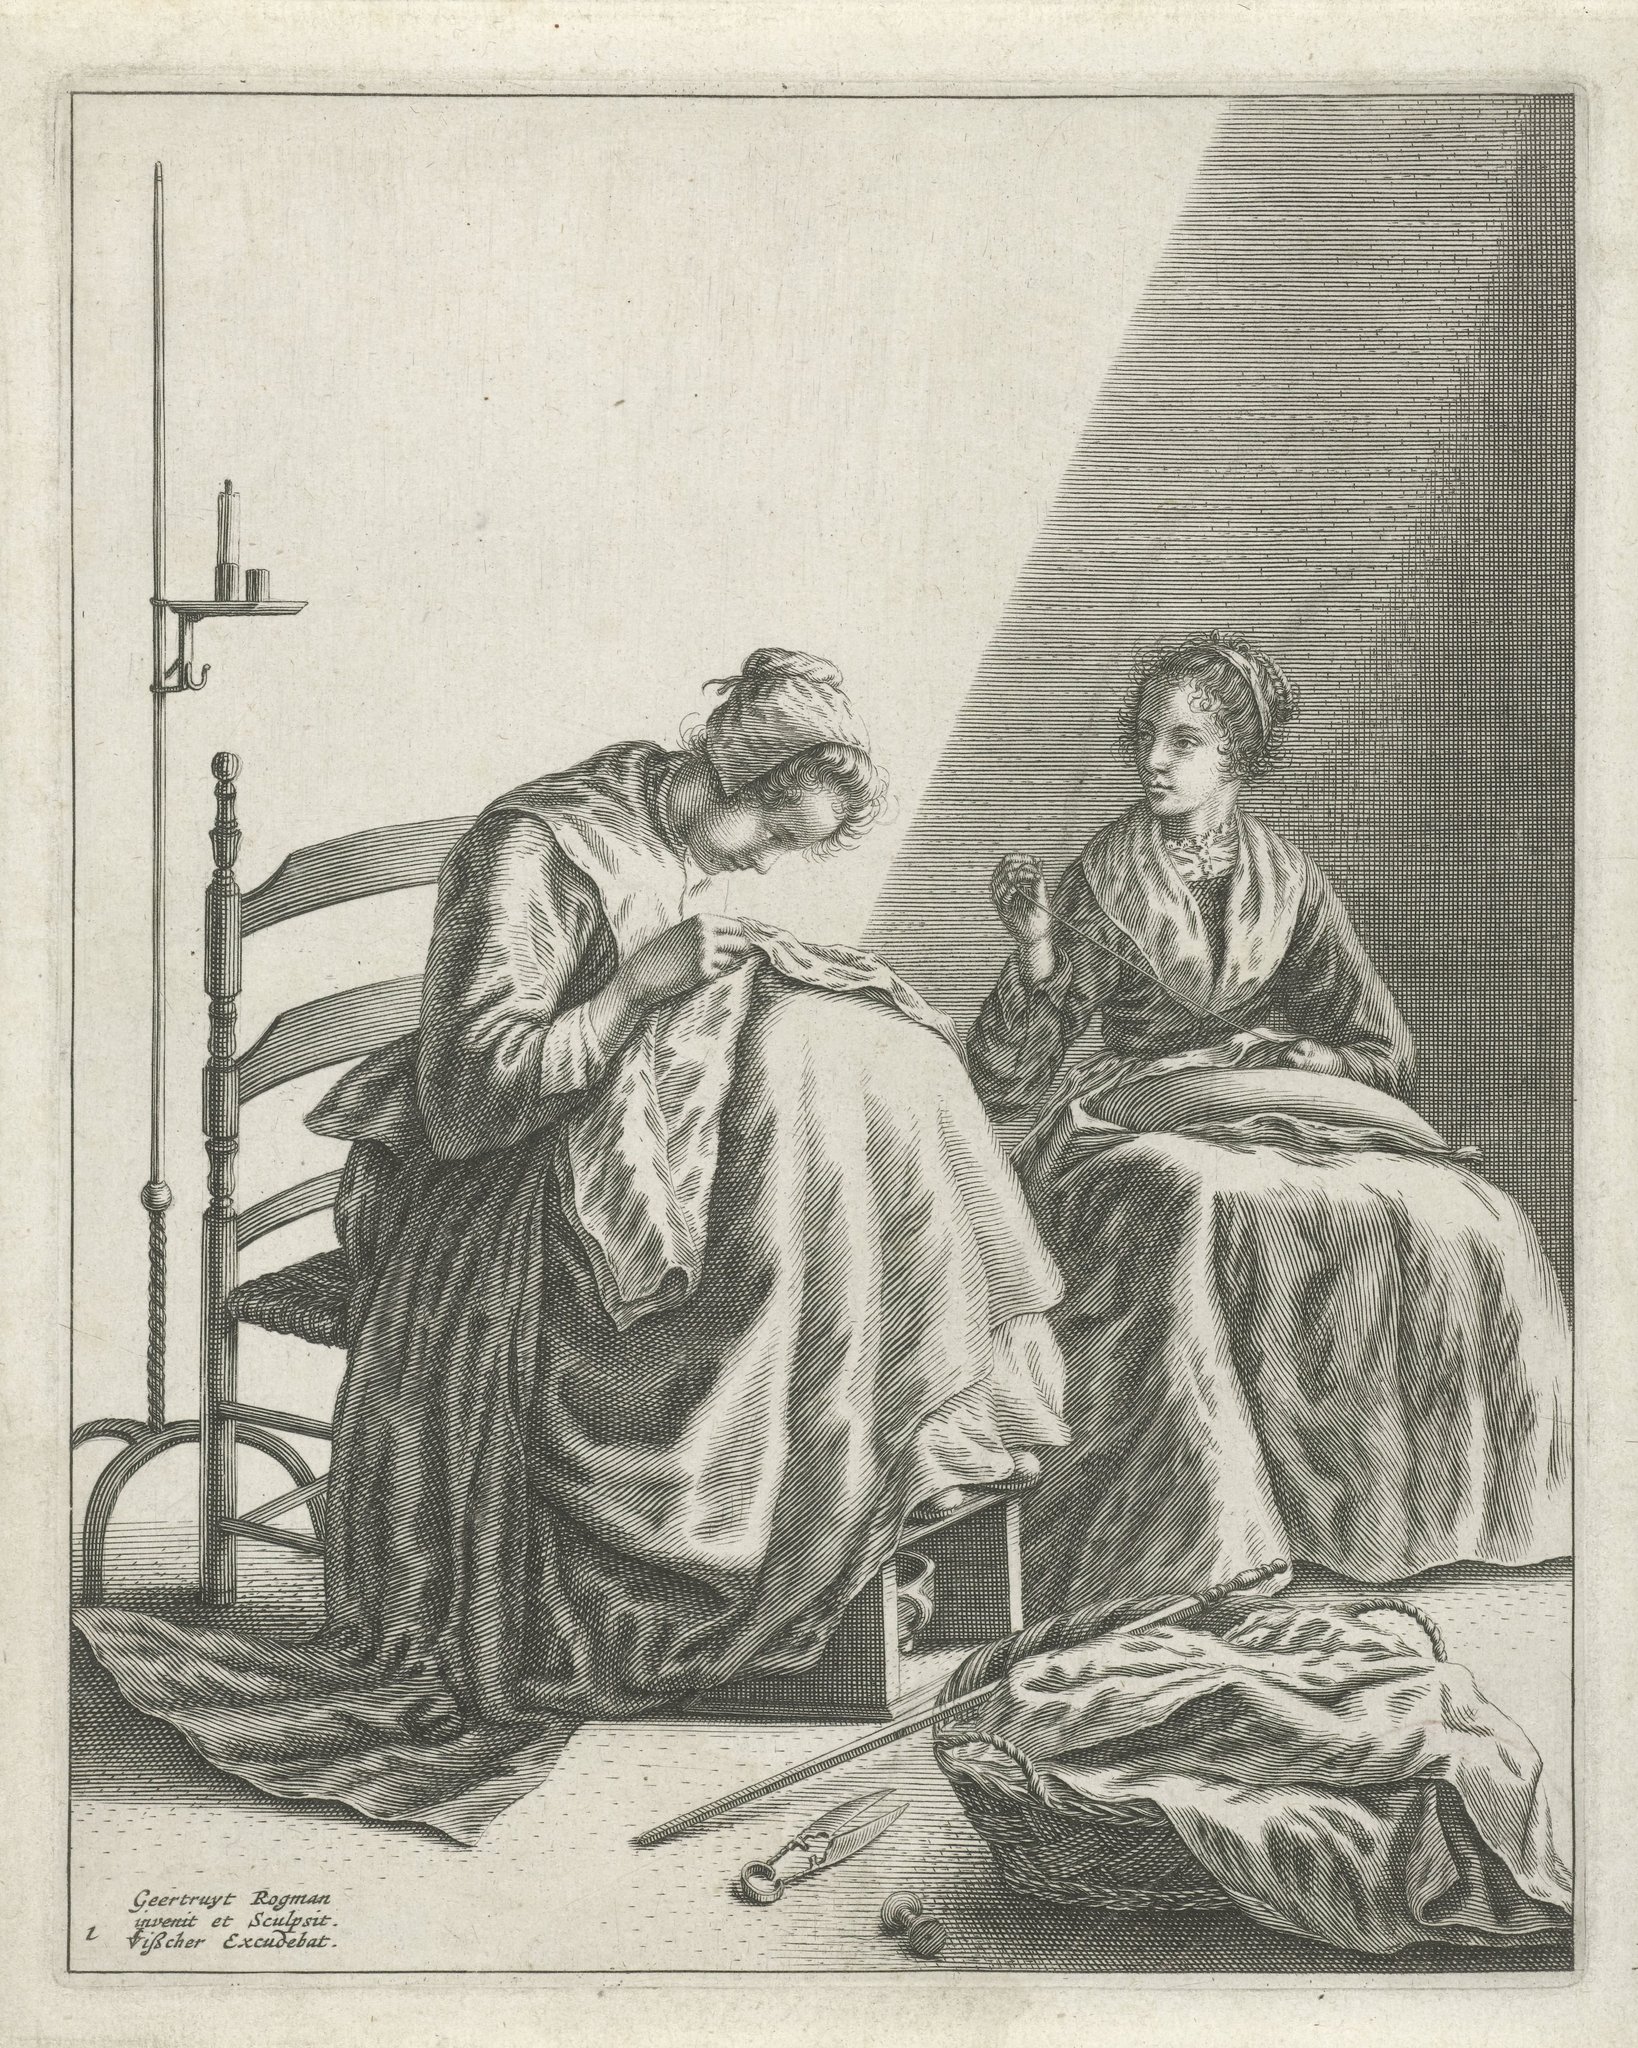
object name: print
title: Huiselijke werkzaamheden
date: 1648-1650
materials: paper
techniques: engraving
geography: amsterdam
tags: head-gear, dress, gown (+ women's clothes), tools, aids, implements ~ crafts and industries: scissors, home sewing; repair of clothes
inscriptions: collector's mark: Lugt 240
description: Twee vrouwen verrichten verstelwerkzaamheden in een vertrek. Op de grond een mand, een maatstok, een schaar en een klosje garen. Links een hoge kandelaar. De prent maakt deel uit van een serie van vijf prenten met huiselijke werkzaamheden.